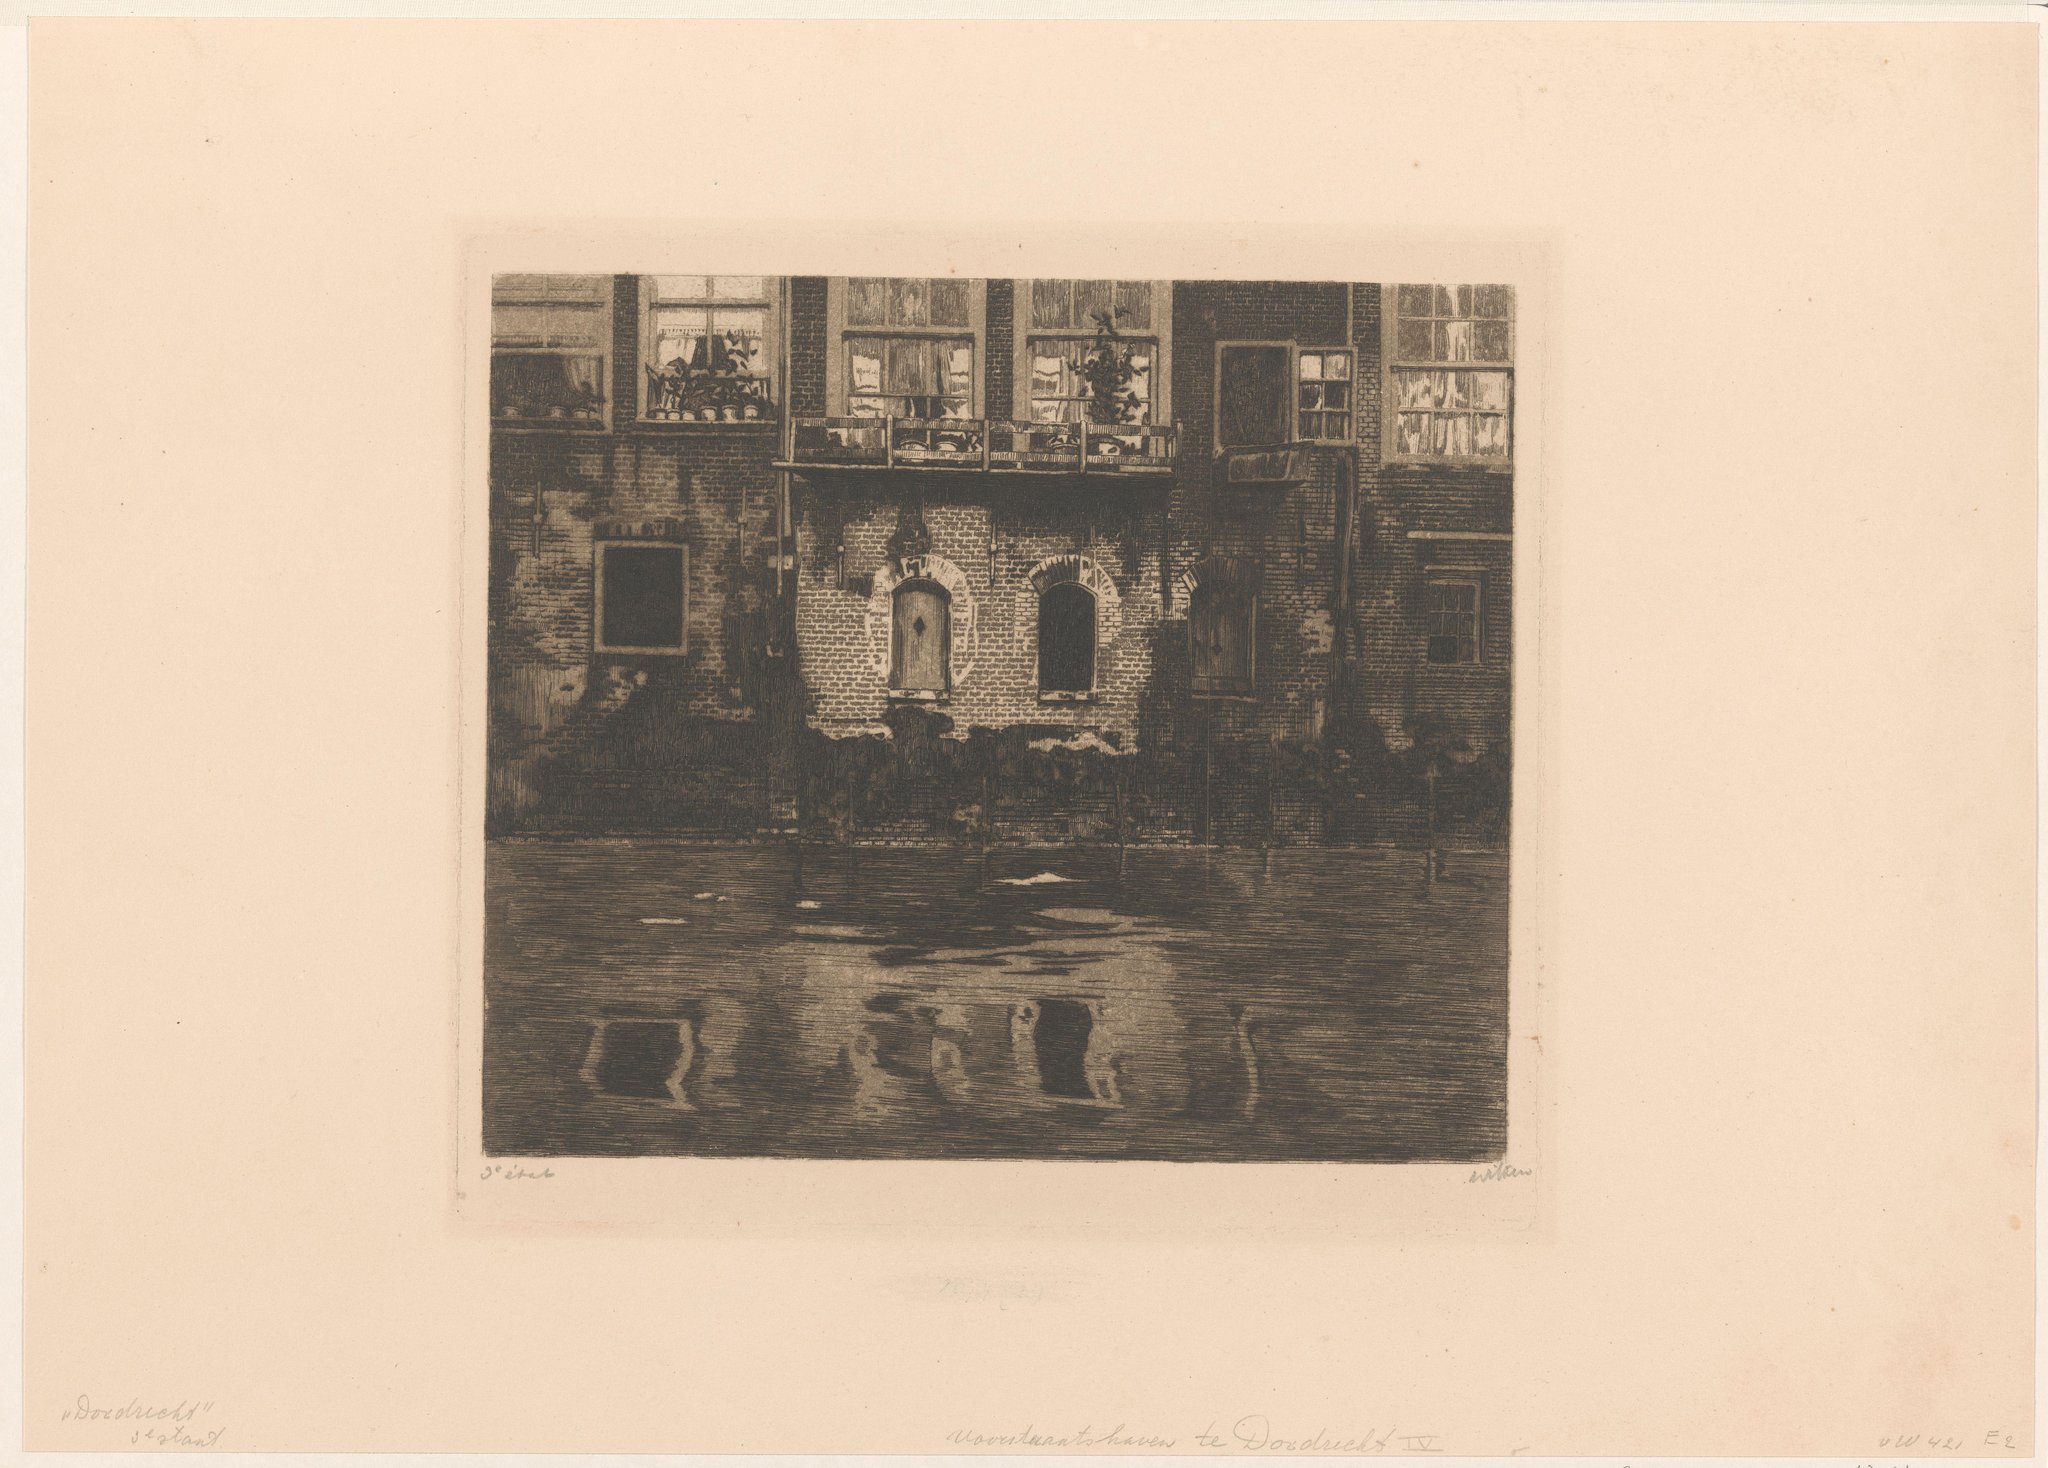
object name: print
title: Achtergevels van de Voorstraat 433, 435 en 437 in Dordrecht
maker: willem witsen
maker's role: draughtsman, painter, print maker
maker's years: 1860-1923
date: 1900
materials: paper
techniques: aquatint, etching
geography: amsterdam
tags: urban housing, window, canals, waters (in city)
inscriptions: inscription: ‘3e staat’, collector's mark: Lugt 2228, collector's mark: Lugt 2760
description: Gezicht op de achtergevels van de Voorstraat 433, 435 en 437, tussen de Pelserbrug en de Ruitensteiger in Dordrecht.